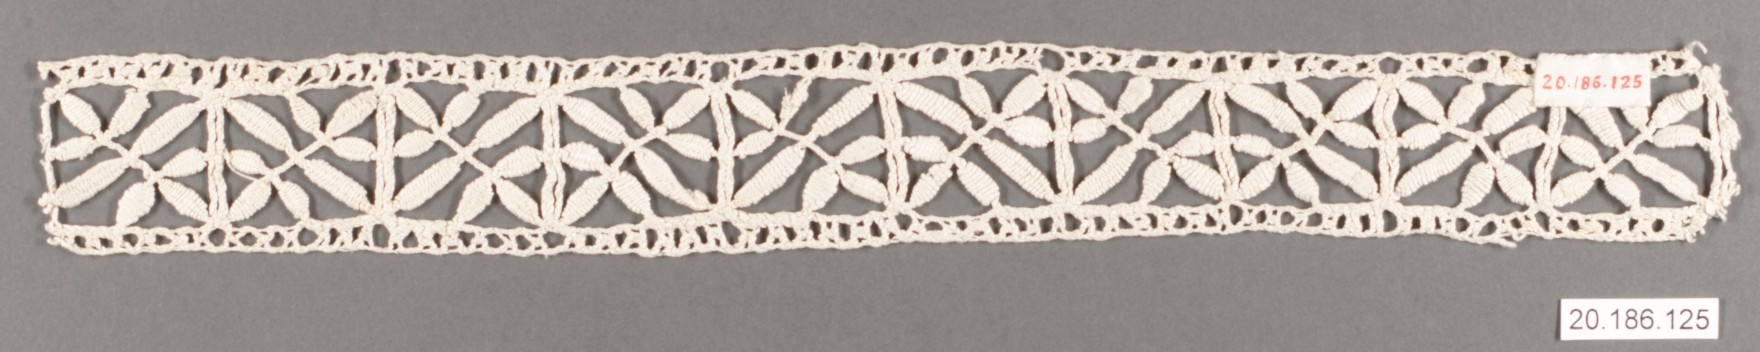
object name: insertion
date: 1501-1700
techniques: lace